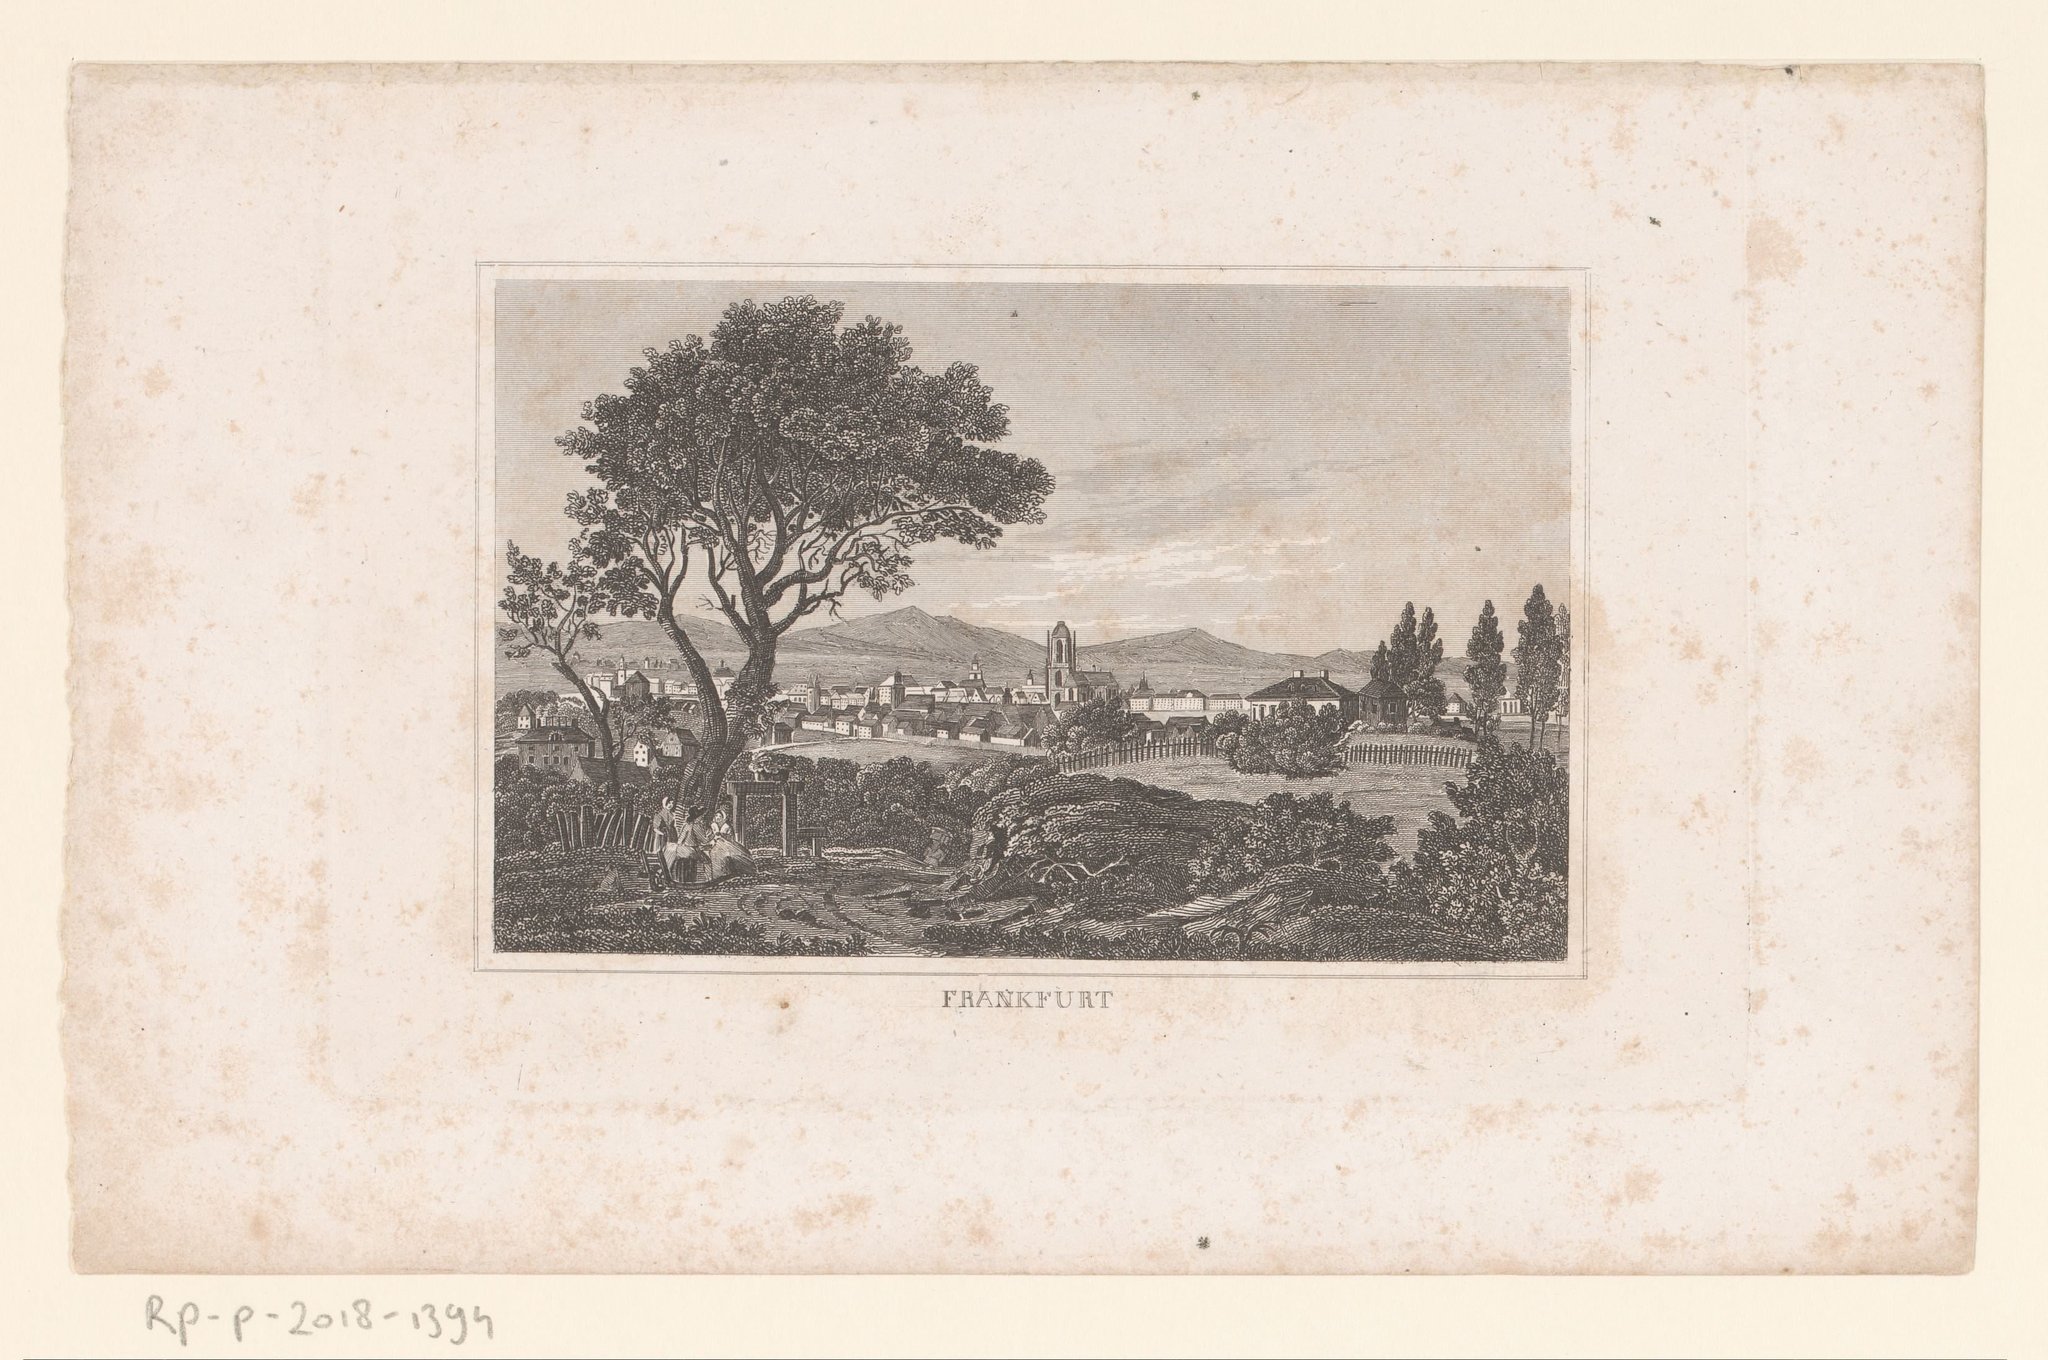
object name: print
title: Frankfurt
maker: Anonymous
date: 1800-1899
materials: paper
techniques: etching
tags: prospect of city, town panorama, silhouette of city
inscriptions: collector's mark: Lugt 2228